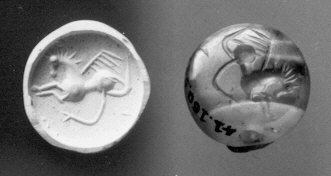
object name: stamp seal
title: Stamp seal (scaraboid) with monster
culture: urartian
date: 900-601 BCE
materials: stone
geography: syria or anatolia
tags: animals